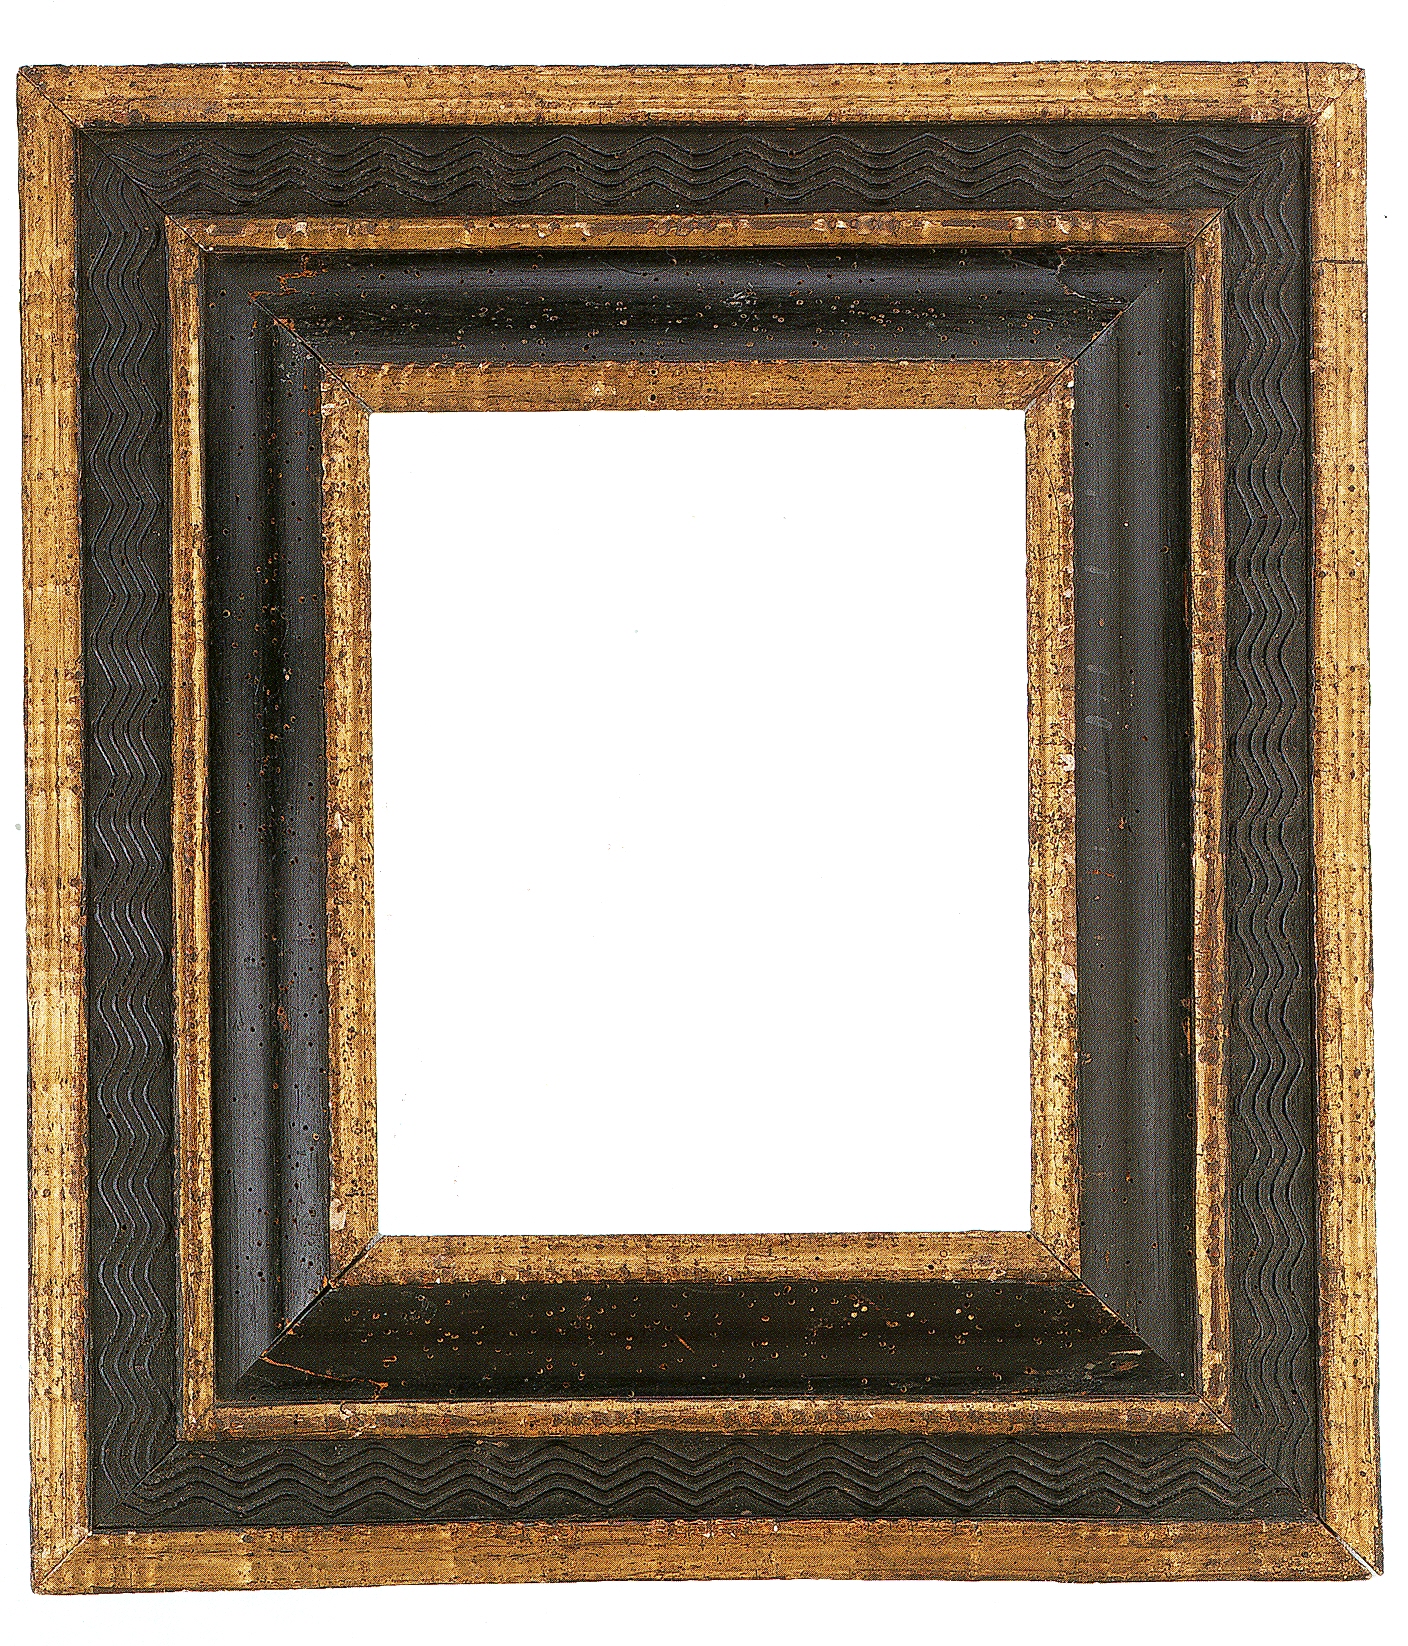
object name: frame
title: Reverse ripple frame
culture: southern italian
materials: wood